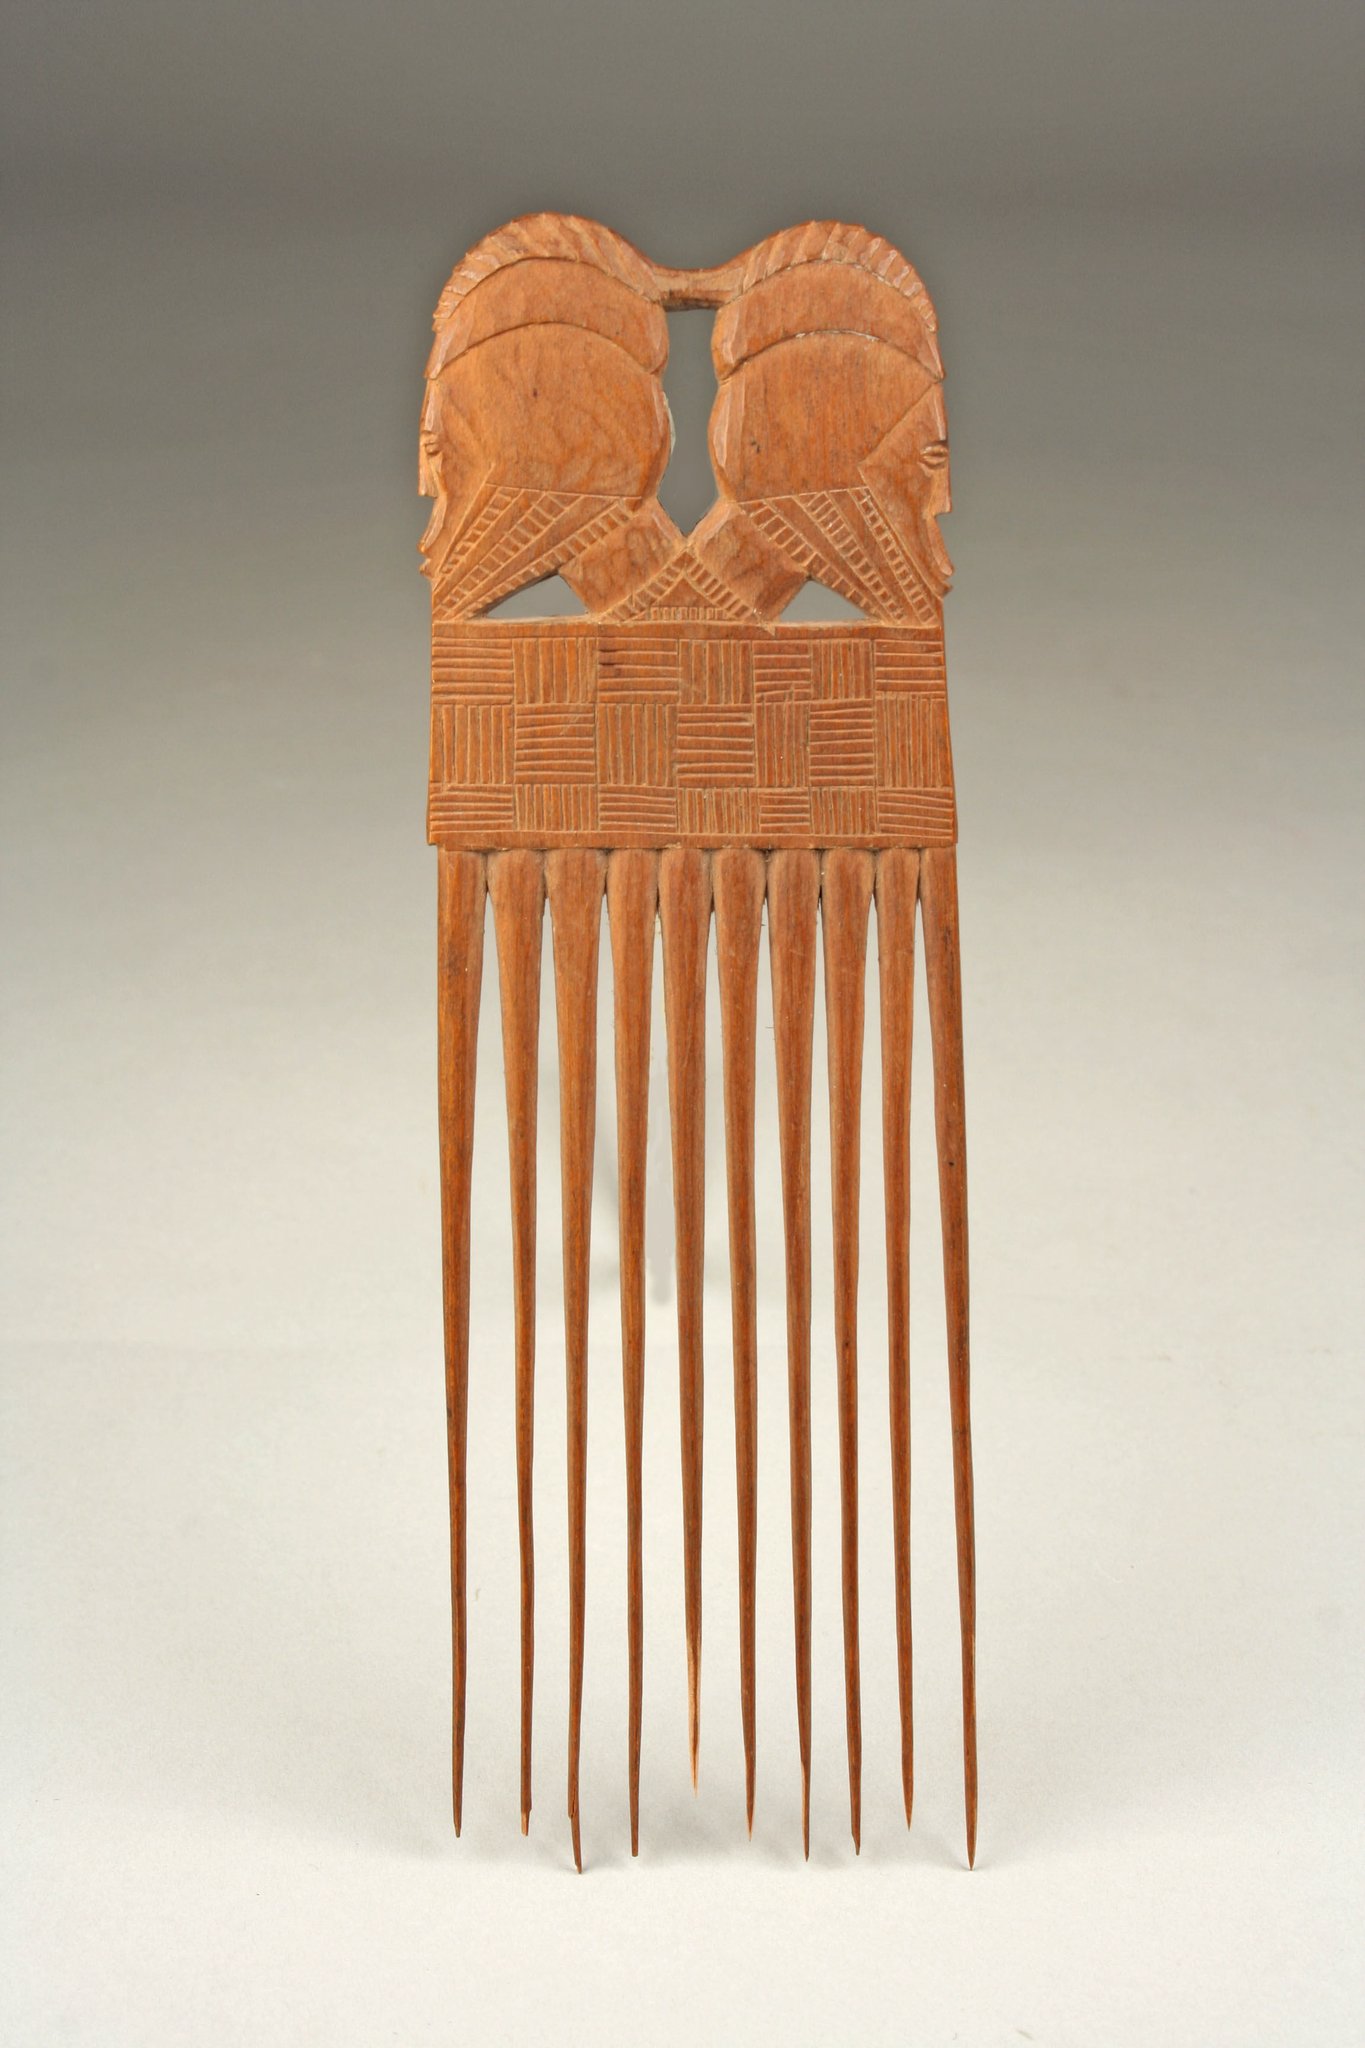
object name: comb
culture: kaniet islands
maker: kaniet islands artist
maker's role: artist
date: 1801-1900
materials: wood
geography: papua new guinea